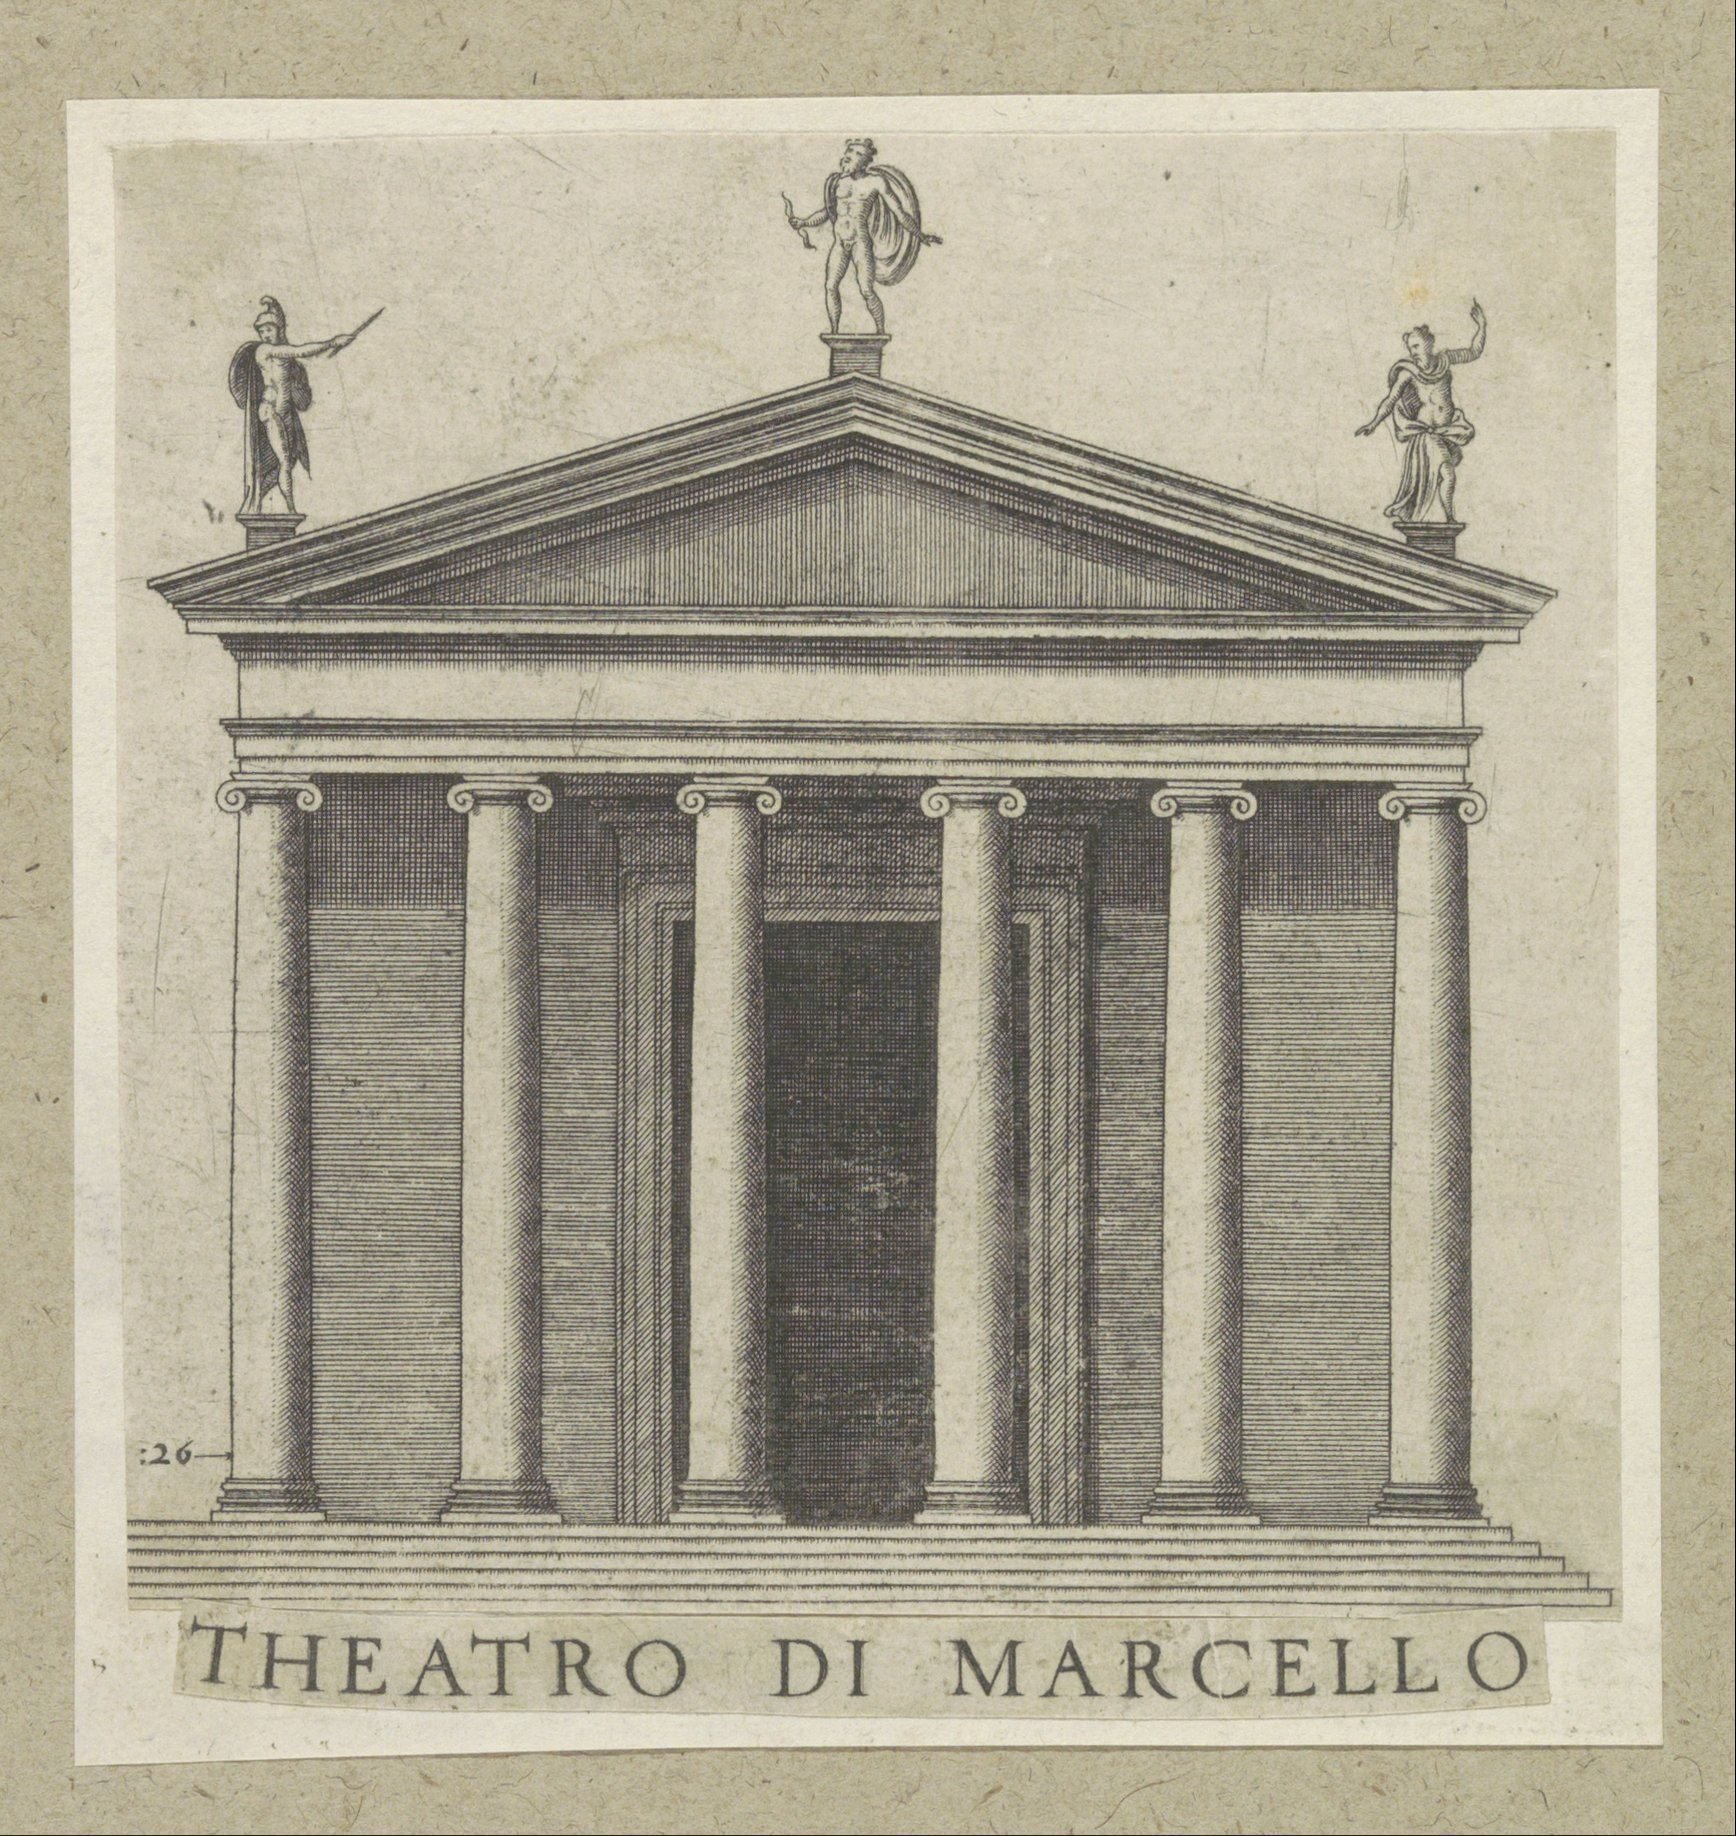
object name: album leaf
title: Romeinse tempel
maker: Anonymous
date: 1550-1650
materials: paper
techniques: etching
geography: italy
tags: temple, shrine ~ roman religion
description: De strook met de titel is los en onder de voorstelling geplakt.